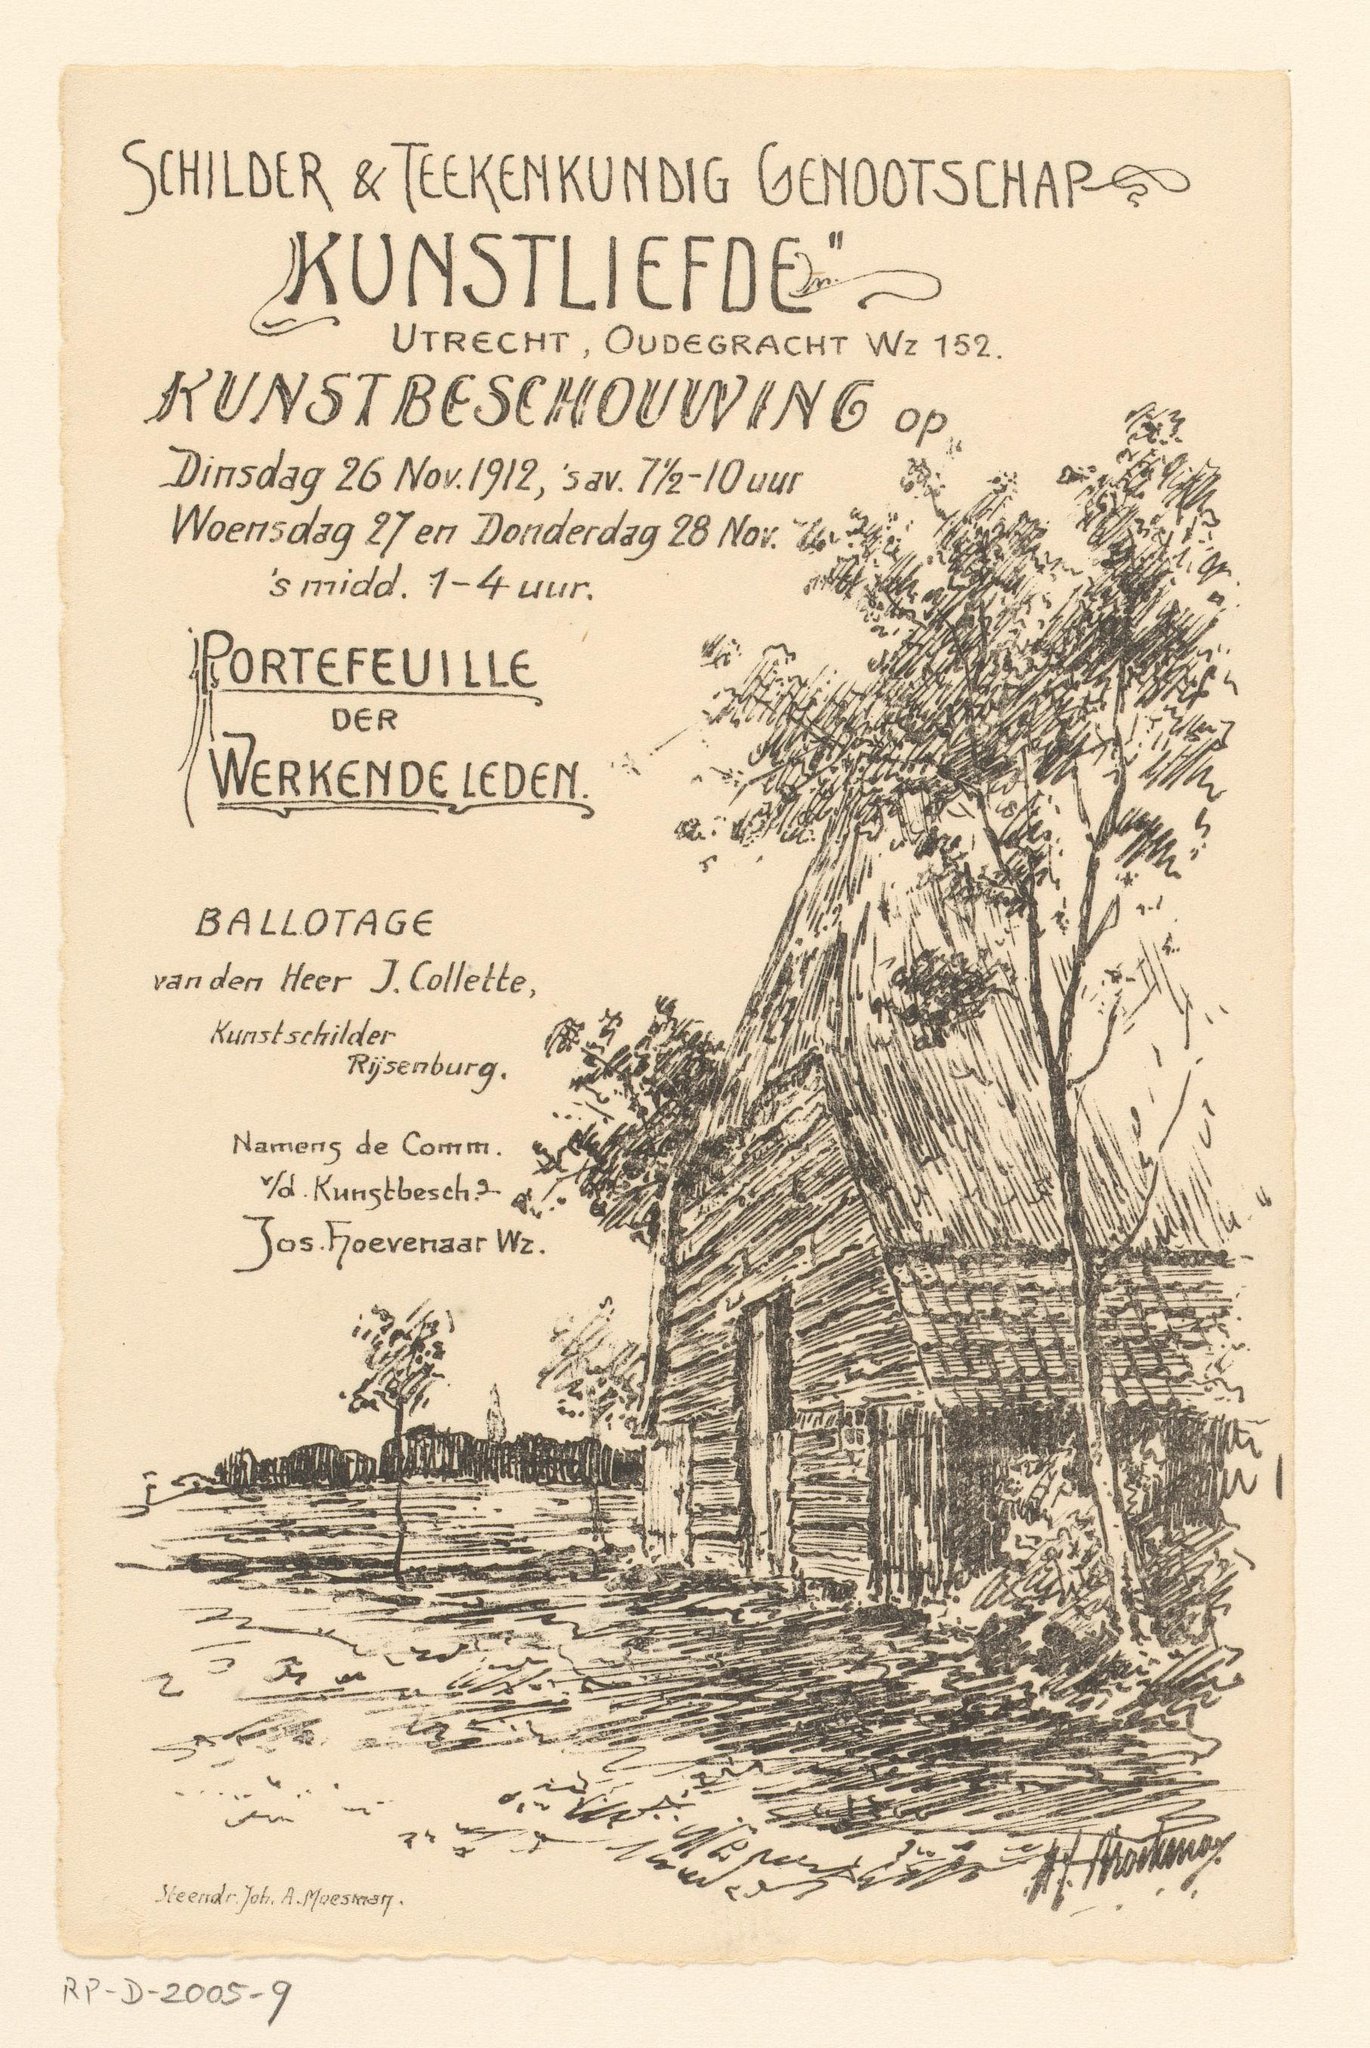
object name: print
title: Uitnodiging van Schilder- en Teekenkundig Genootschap "Kunstliefde" voor een kunstbeschouwing, 26-28 november 1912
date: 1911-1912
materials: paper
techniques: lithograph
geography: netherlands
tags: criticizing and discussing art, art criticism, circle, club of artists, collecting and exhibiting products of the fine arts, farm or solitary house in landscape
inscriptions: collector's mark: Lugt 2228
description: Boerderij. Uitnodiging van Schilder- en Teekenkundig Genootschap "Kunstliefde" voor een kunstbeschouwing op 26-28 november 1912 van de portefeuille van de werkende leden.